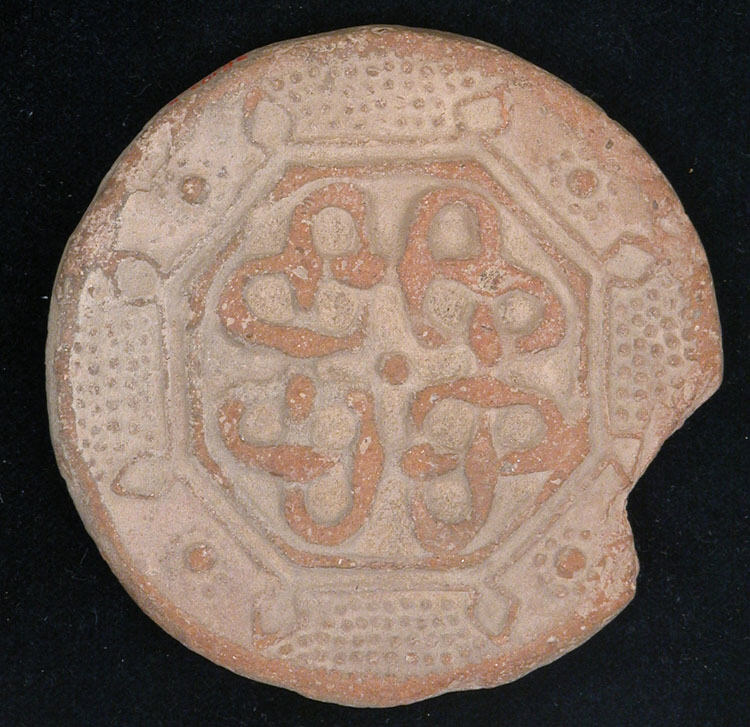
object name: bath scraper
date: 1101-1300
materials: earthenware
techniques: molding, relief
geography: iran